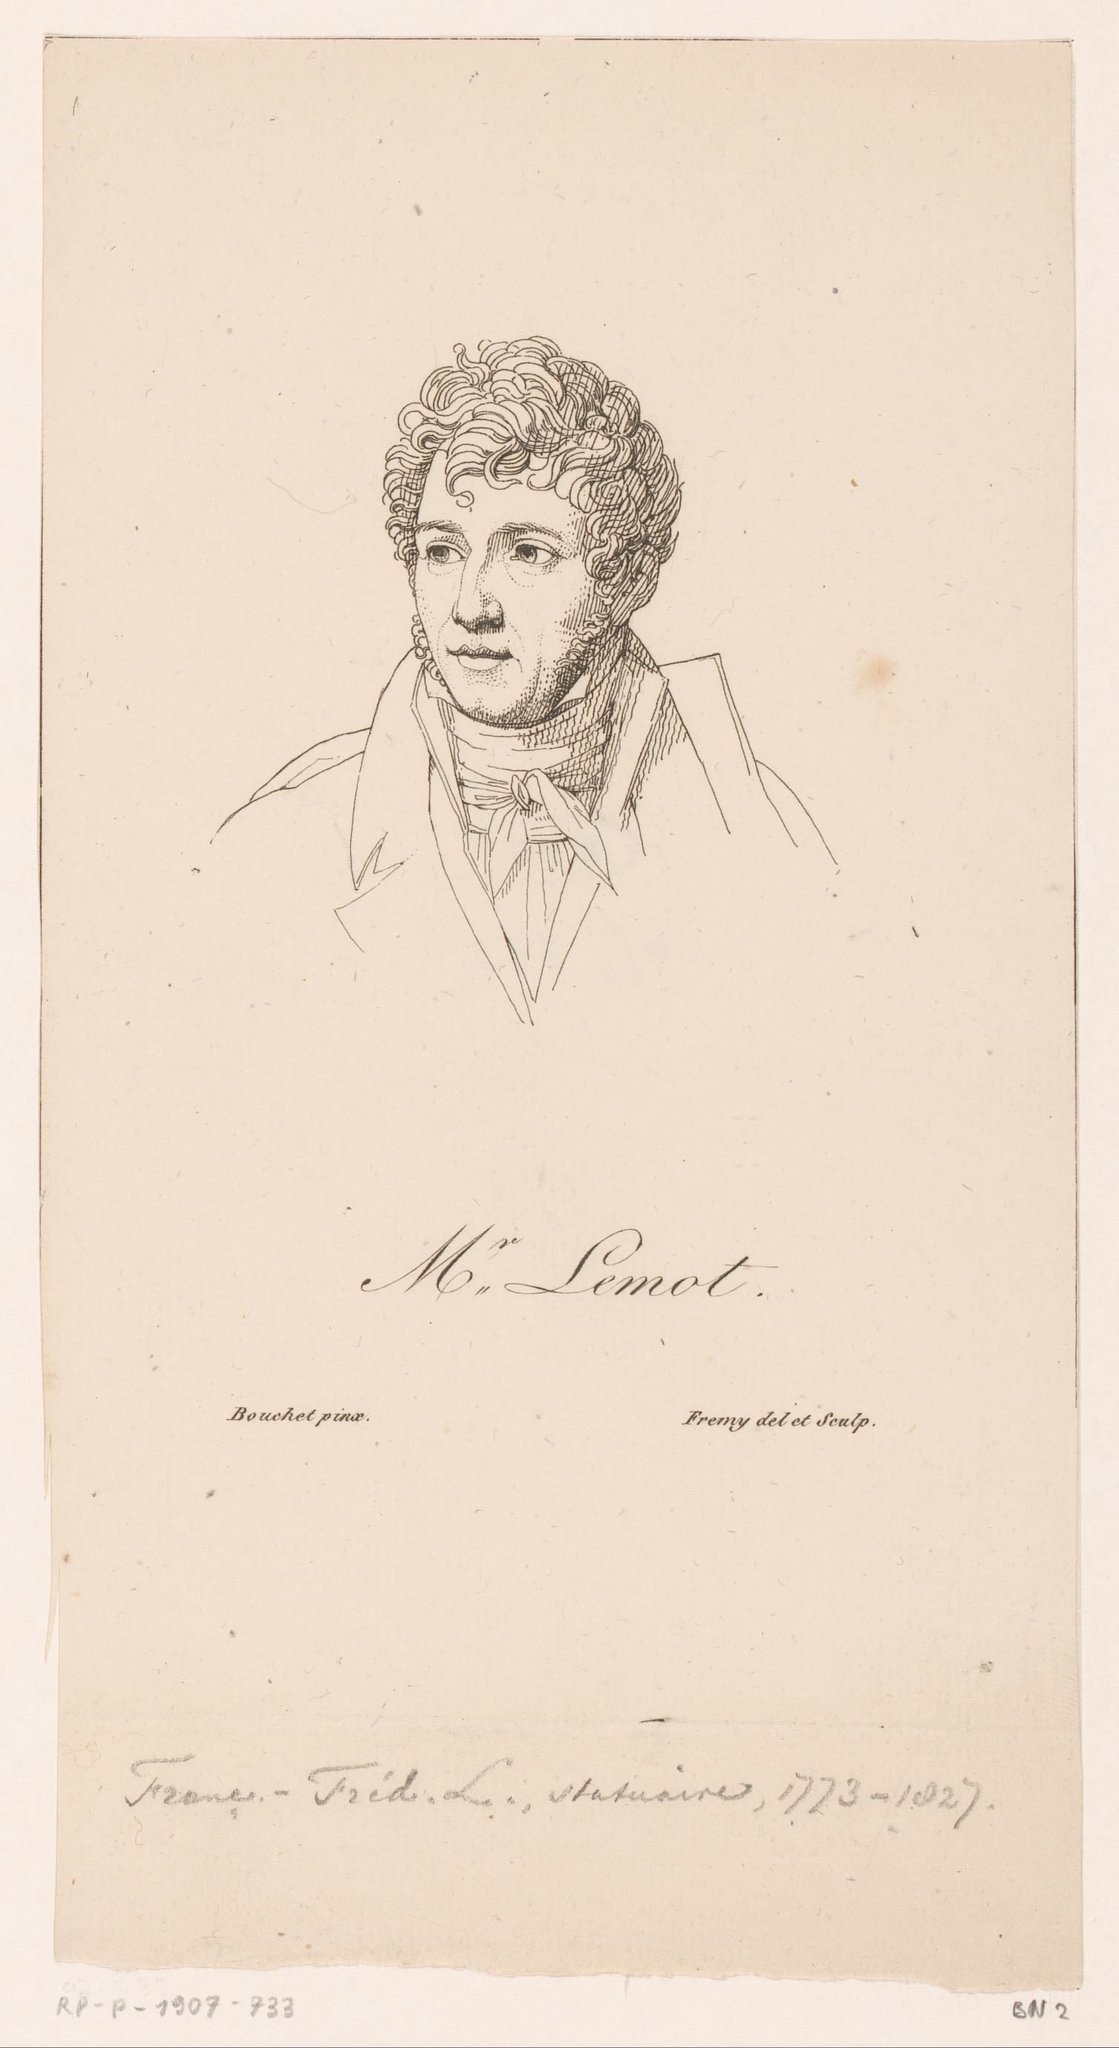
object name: print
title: Mr. Lemot.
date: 1815-1817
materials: paper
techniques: etching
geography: france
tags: lyon, paris, portrait, self-portrait of sculptor, historical persons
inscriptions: collector's mark: Lugt 2228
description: Prent uit: Frémy, Jacques Noël Marie. Croquis de portraits des personnages remarquables dans tous les genres, dessinés et gravés. Parijs: Jacques Noël Marie Frémy, 1815-1817.